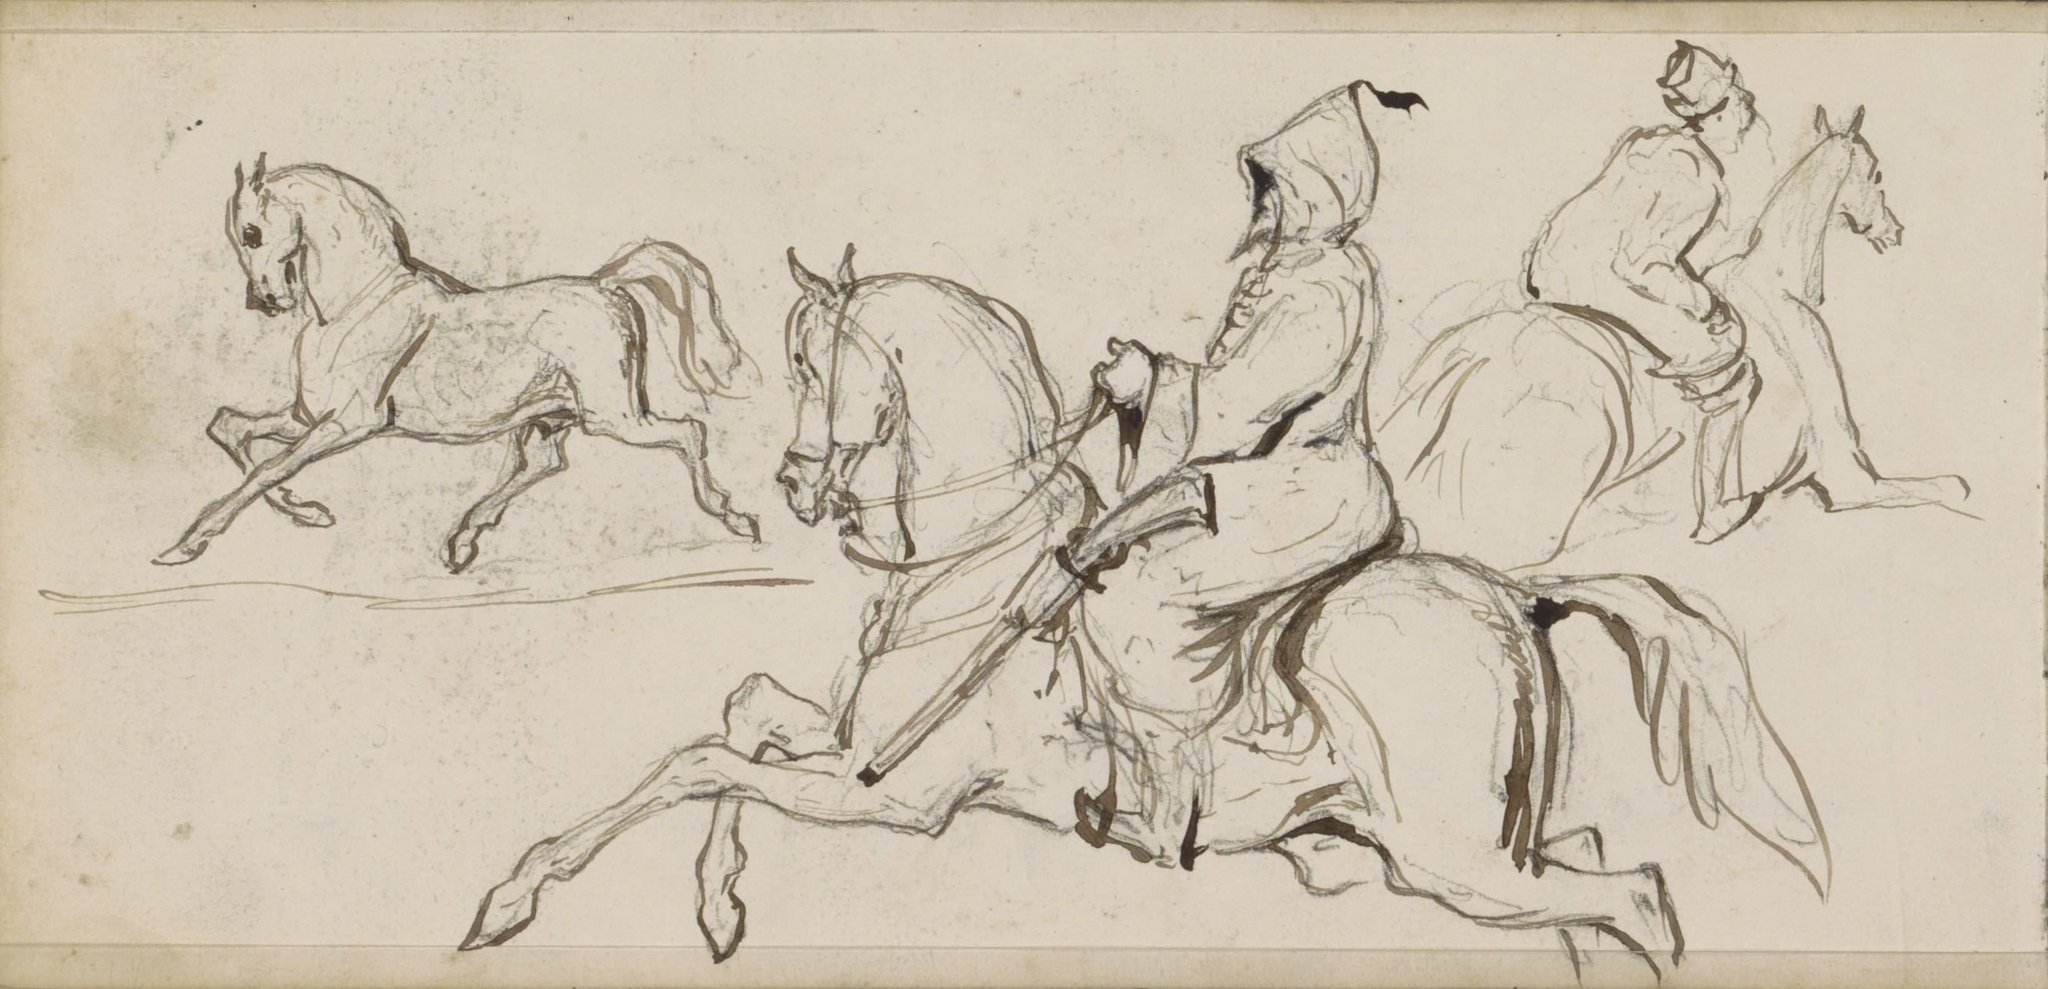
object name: sketchbook leaf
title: Paard en ruiters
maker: johannes tavenraat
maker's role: draughtsman, painter, print maker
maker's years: 1809-1881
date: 1840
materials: ink, paper, pencil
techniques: pen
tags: riding a horse, ass, or mule; rider, horseman, horse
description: Eén van de ruiters draagt een mantel met kap, mogelijk een pij. Blad 11 verso uit een schetsboek met 63 bladen.